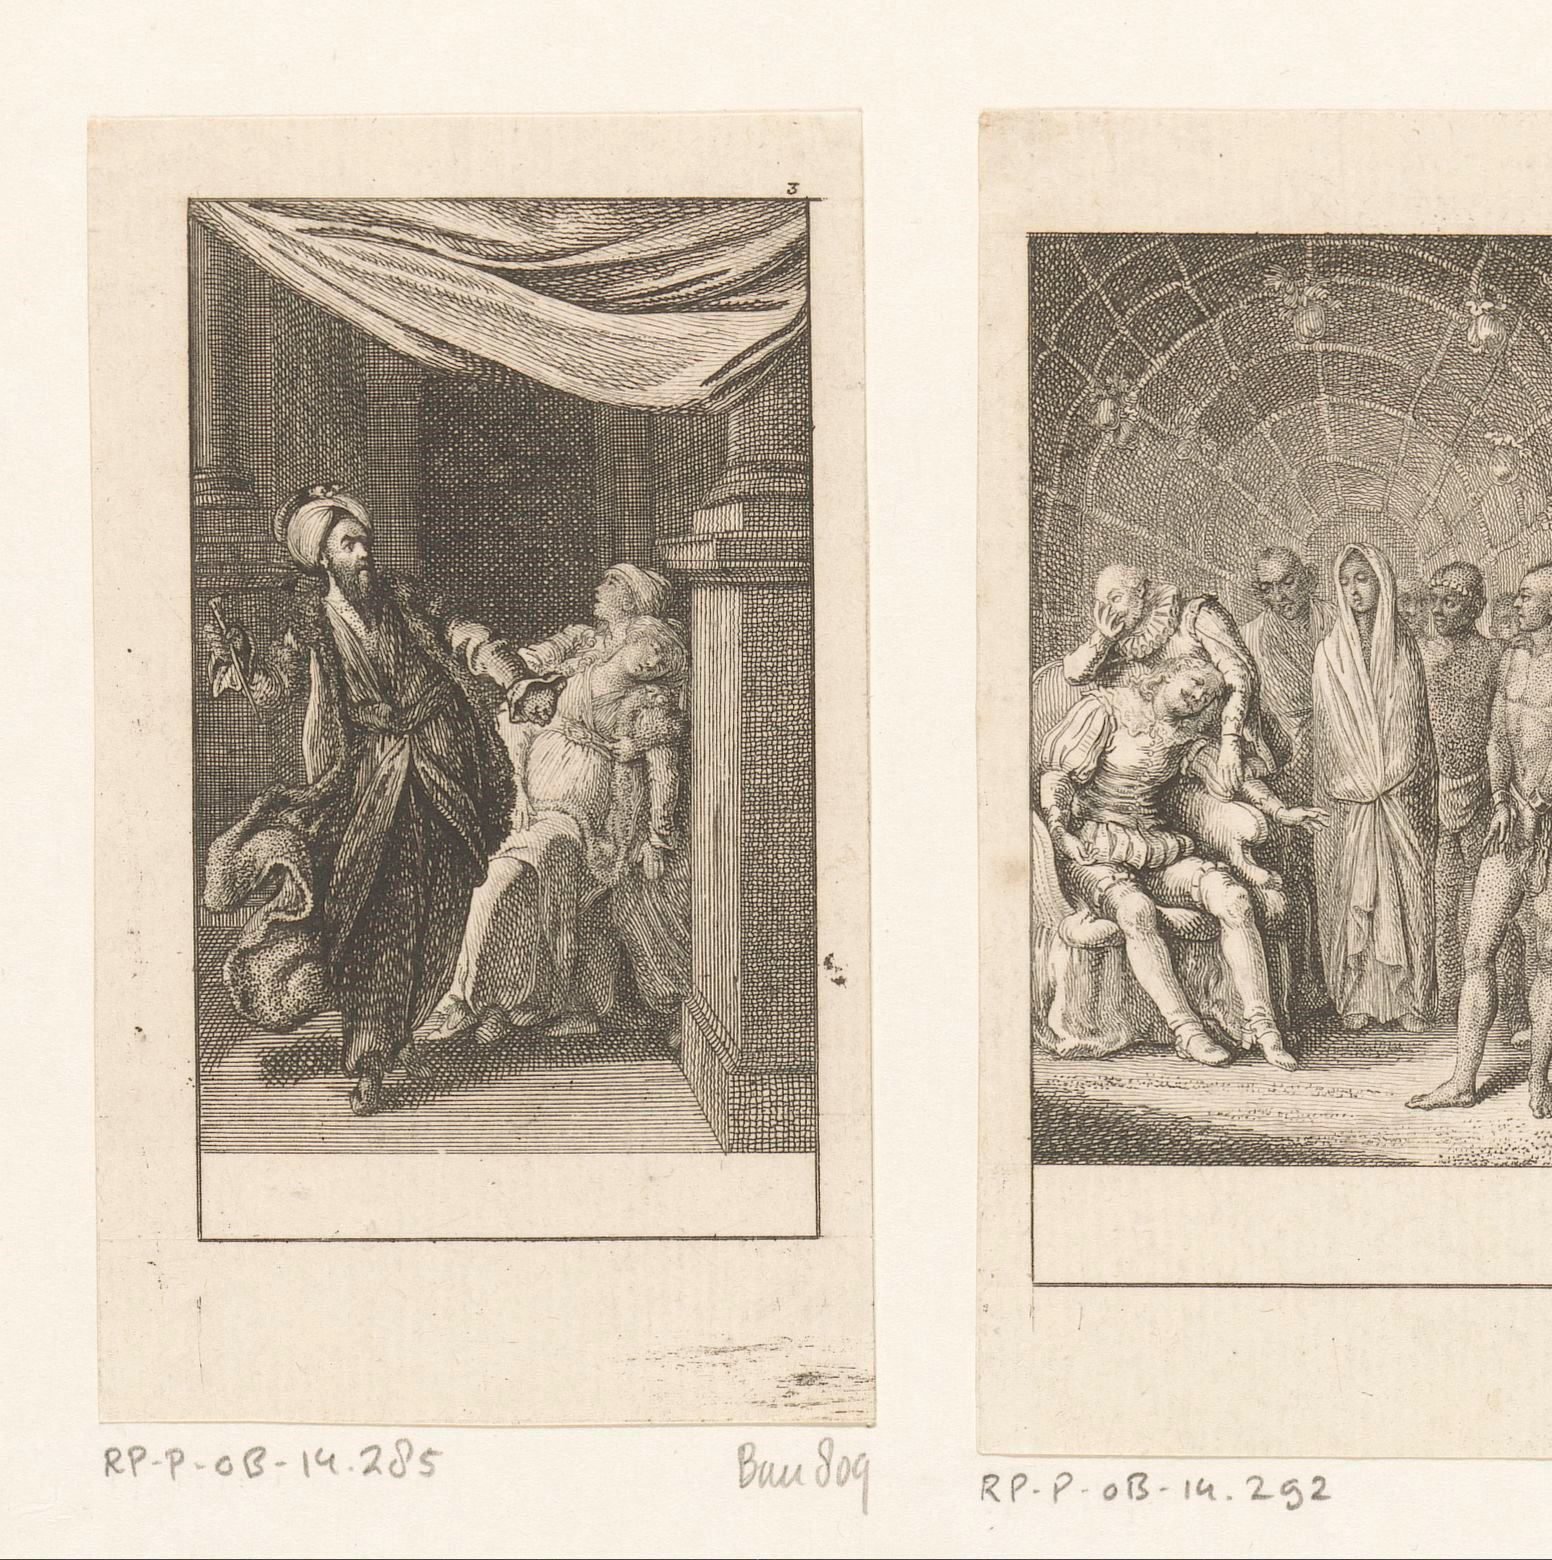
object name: print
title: Orosmane brengt Zaïre om het leven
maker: daniel nikolaus chodowiecki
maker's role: draughtsman, print maker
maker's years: 1726-1801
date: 1781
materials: paper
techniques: etching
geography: berlin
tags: paris, voltaire, falling - aa - female human figure (+ two persons), head-gear: turban, murder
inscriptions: collector's mark: Lugt 2228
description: Deze prent behoort tot een serie van twaalf prenten, vervaardigd voor de geschriften van Voltaire. Prent gebruikt voor: Almanac historique généalogique pour l'année 1782. A Berlin. Berlijn: L'Academie, 1781.